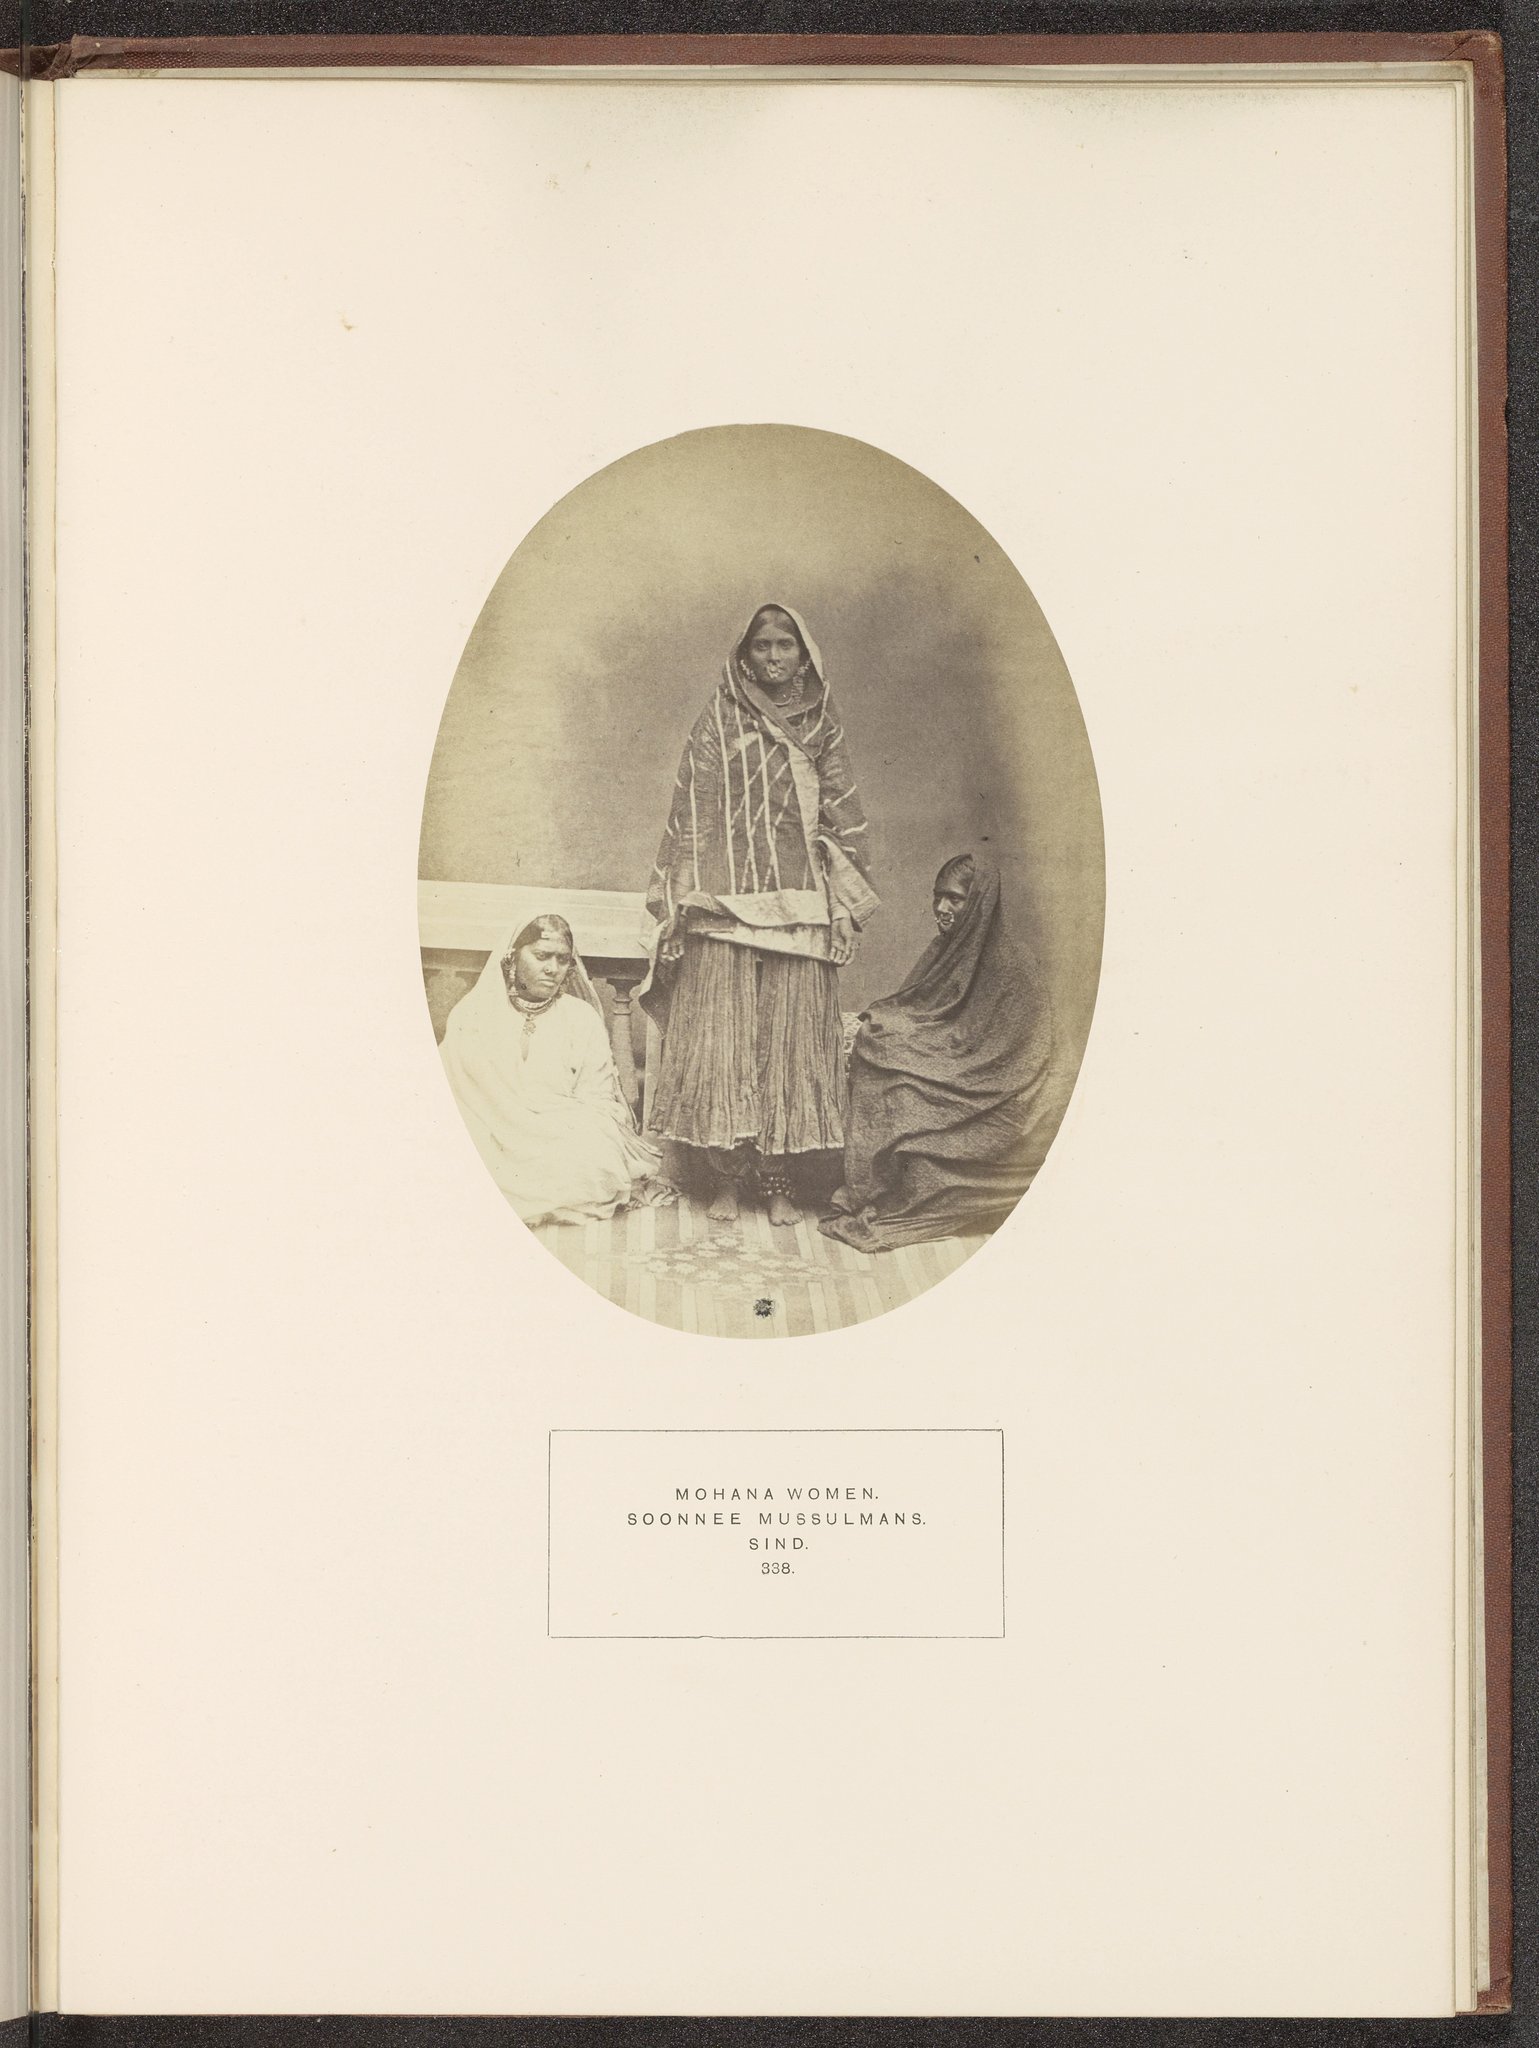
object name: page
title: Portrait of three unknown women from the Mohana tribe in Sindh, Pakistan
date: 1862-1872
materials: photographic support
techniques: albumen print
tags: courtesan, hetaera, human races; peoples; nationalities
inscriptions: inscription: ‘MOHANA WOMEN./ SOONNEE MUSSULMANS./ SIND.’, number: ‘338.’